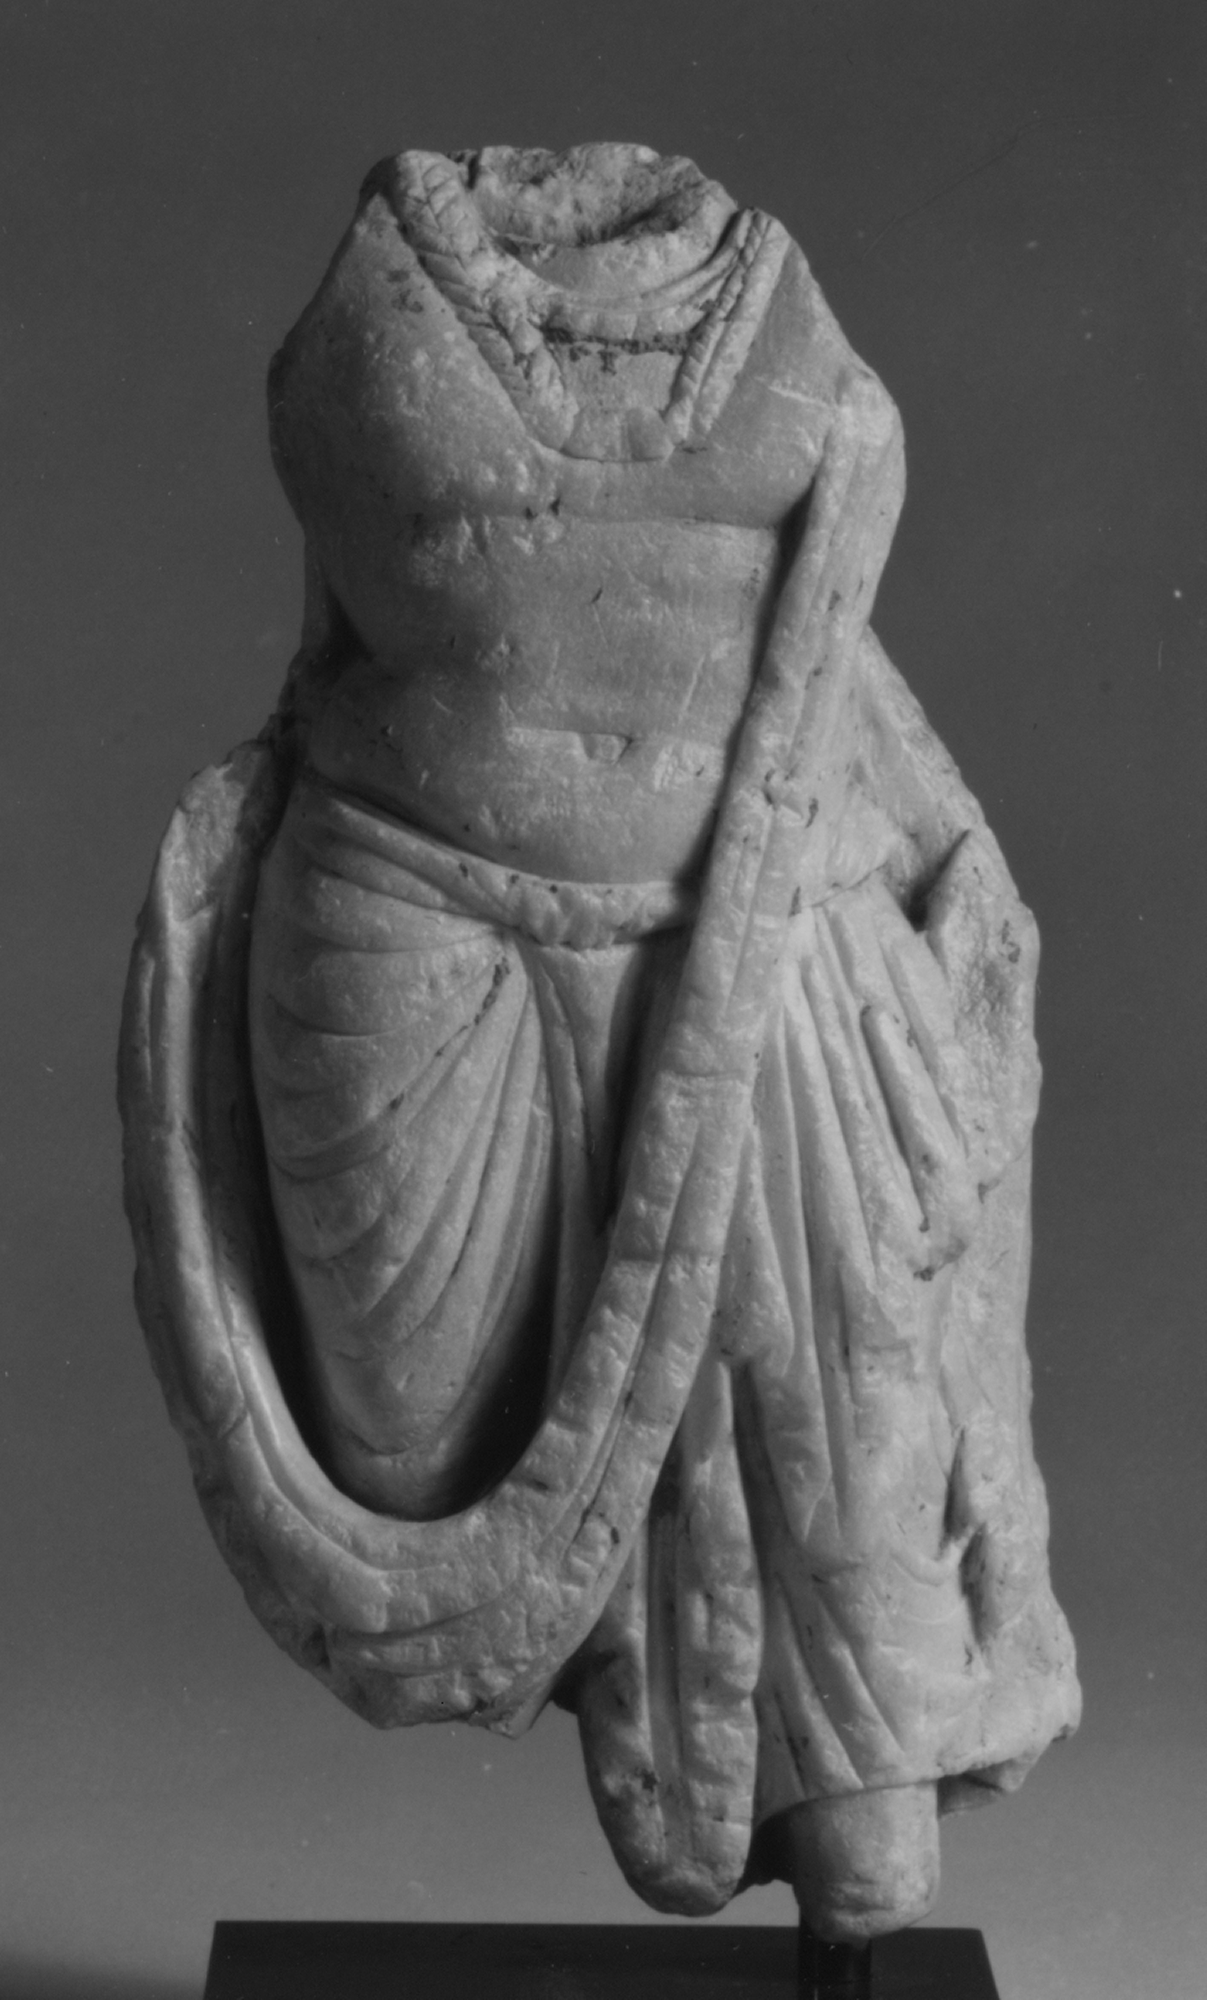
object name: headless figure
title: Standing Bodhisattva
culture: afghan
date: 401-500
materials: gypsum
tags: gandharan,buddhism,bodhisattvas